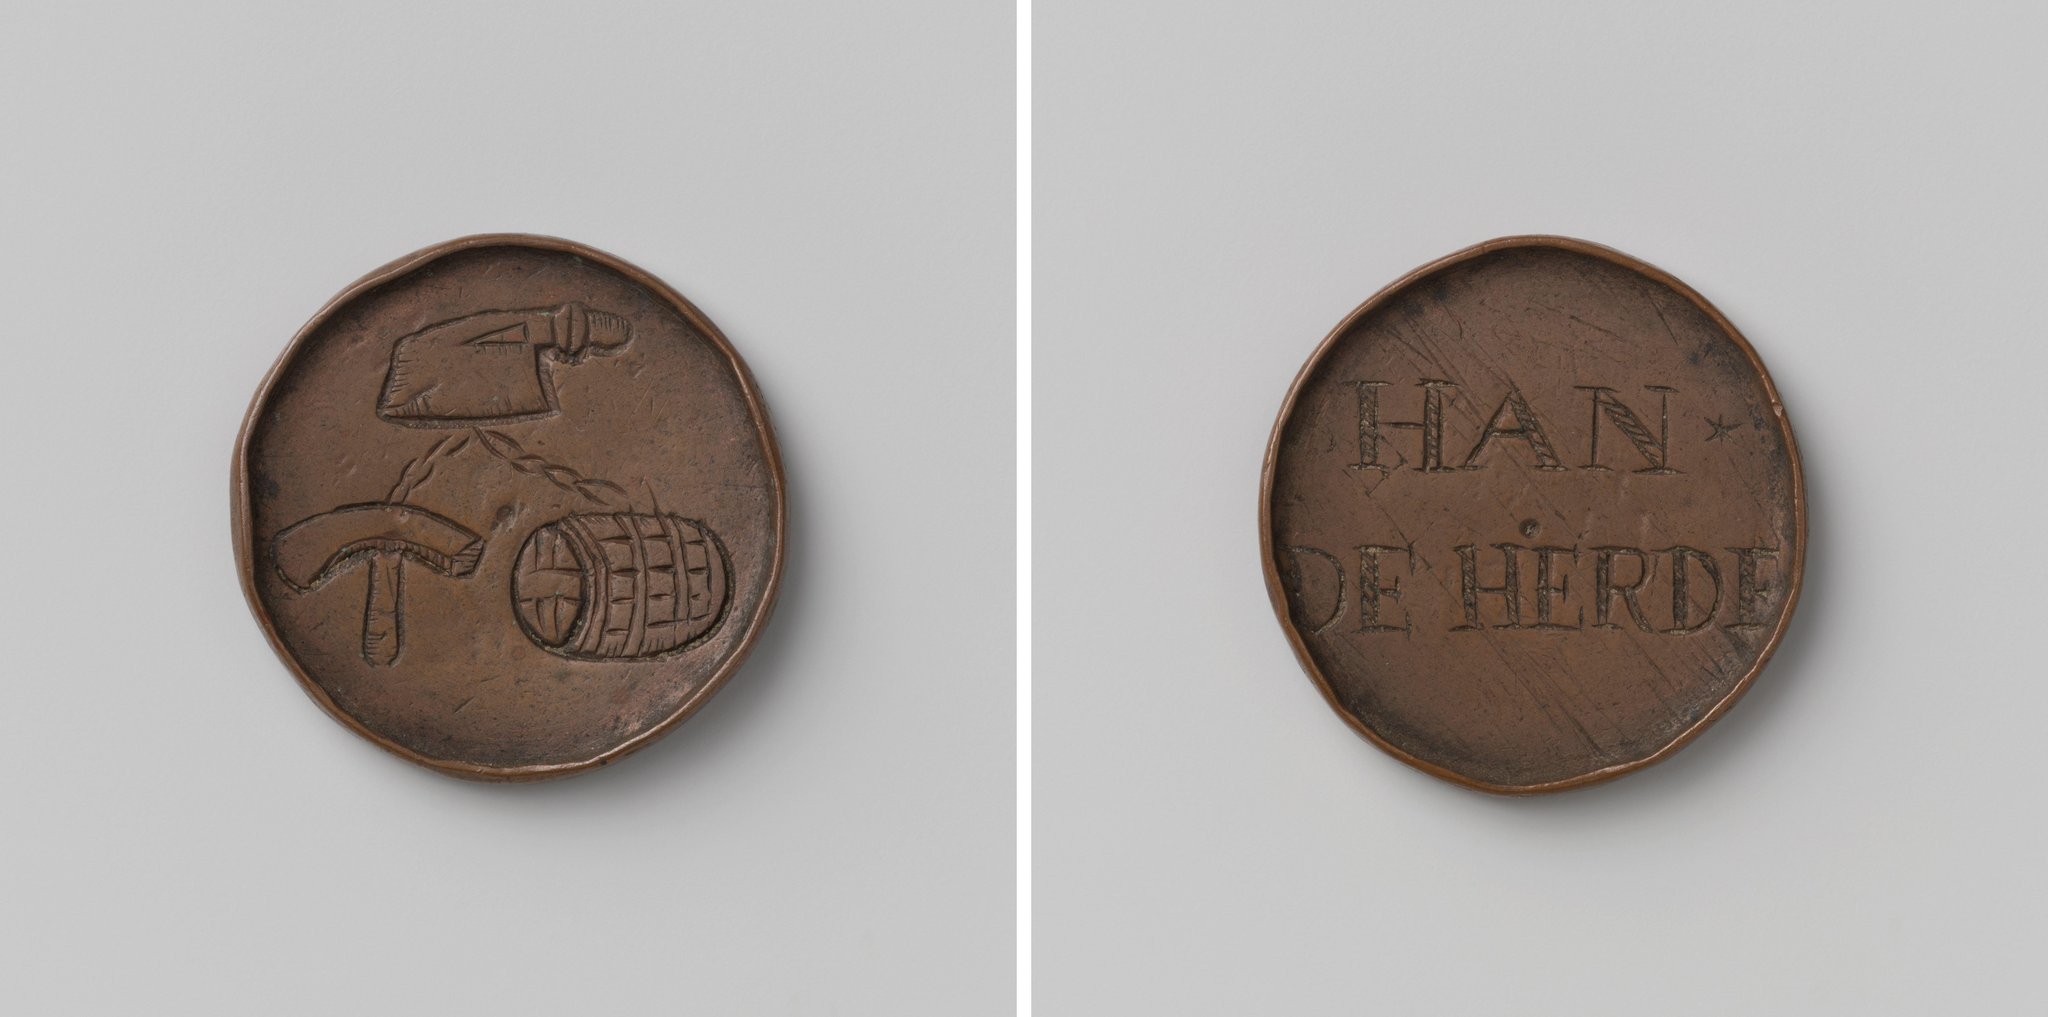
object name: medal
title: Kuipersgilde van Antwerpen, gildepenning van Han de Herde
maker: Anonymous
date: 1600-1750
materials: copper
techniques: engraving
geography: antwerp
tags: antwerp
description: Koperen penning. Voorzijde: kuipershamer en ton, met ketting verbonden met bijl. Keerzijde: opschrift